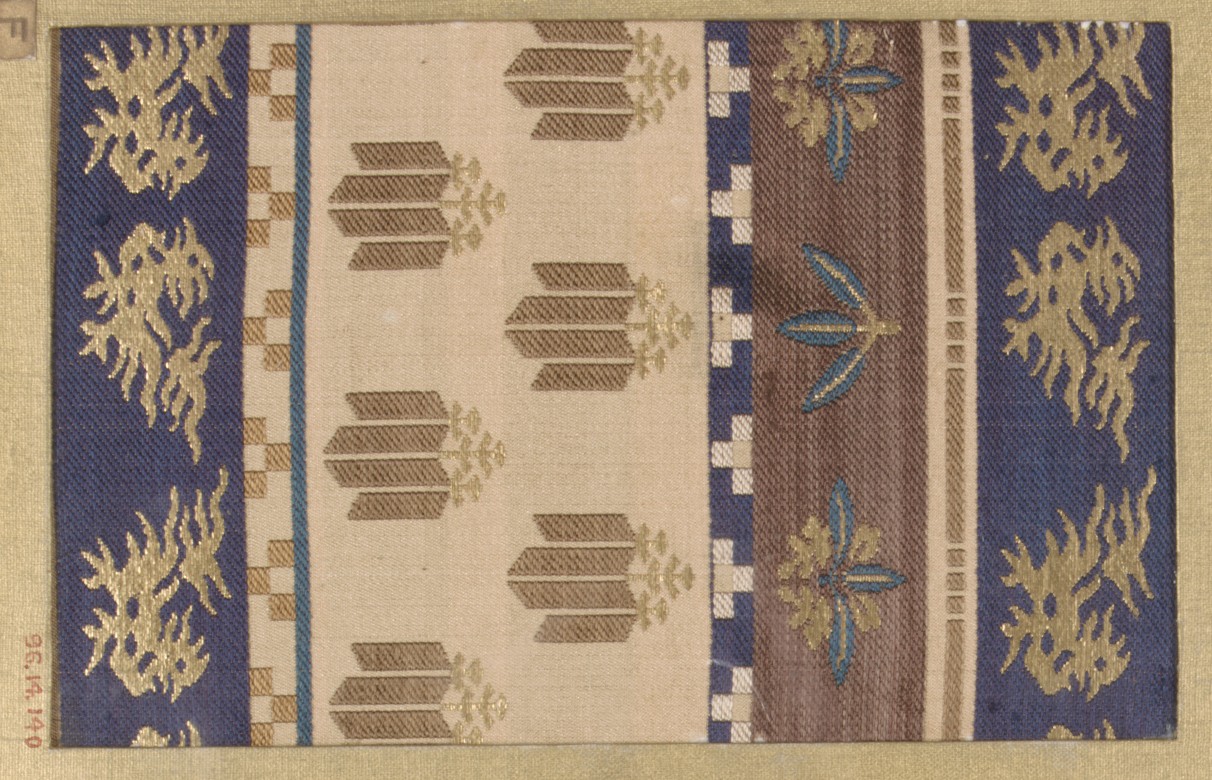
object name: piece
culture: japanese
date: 1701-1900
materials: silk